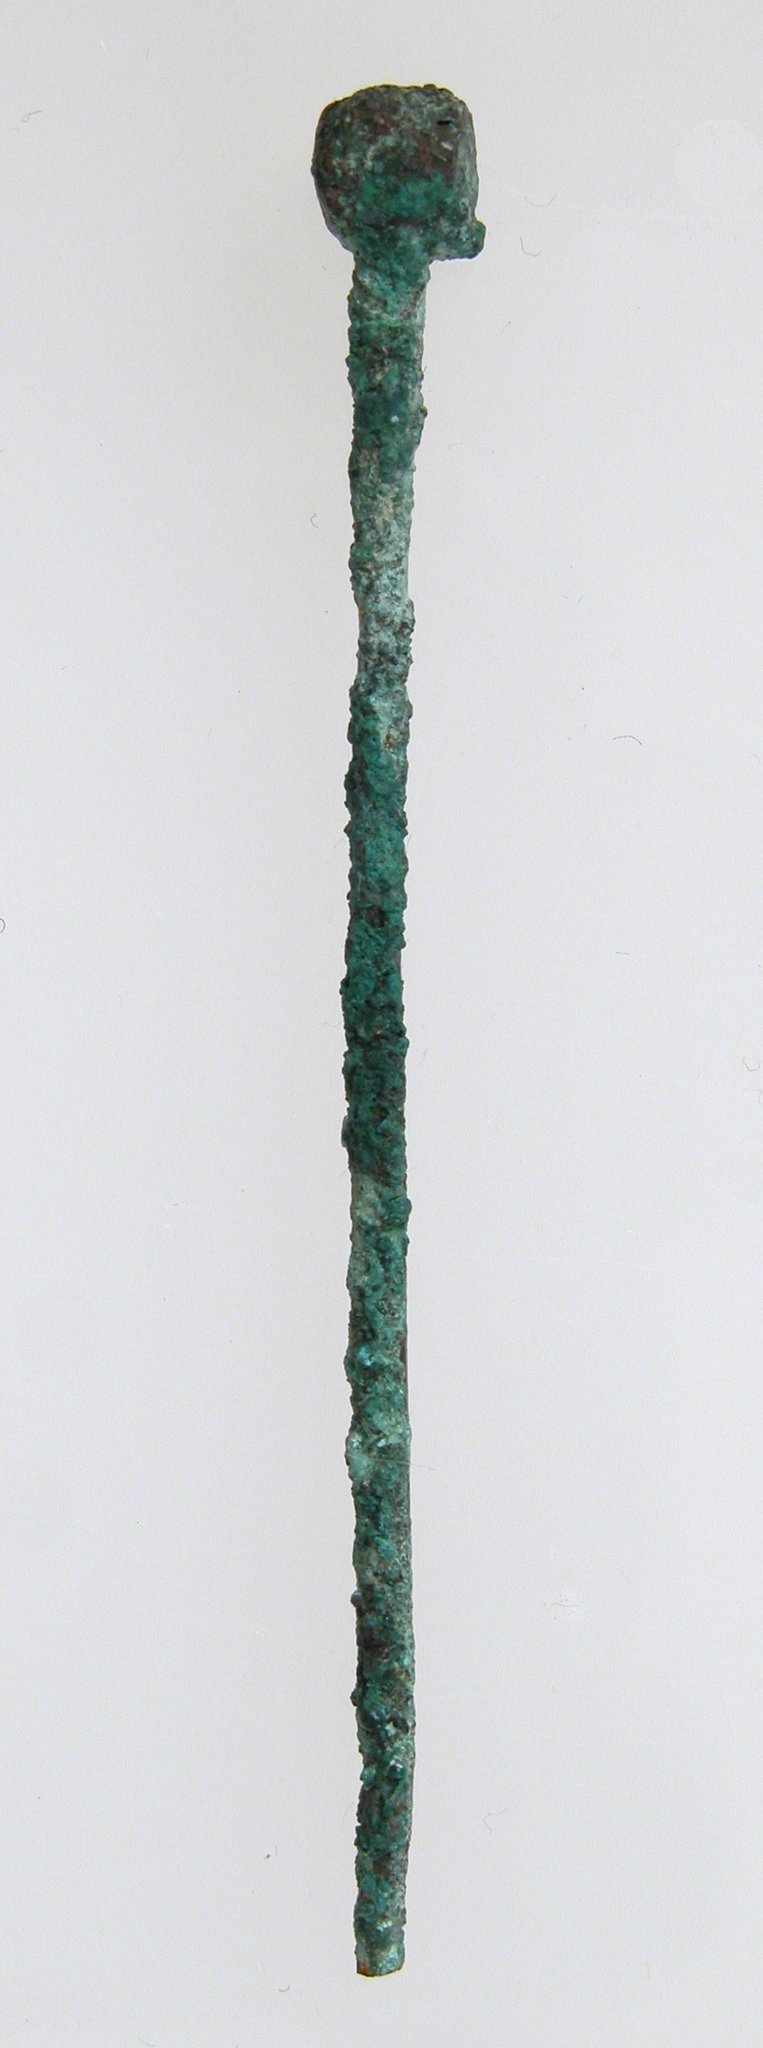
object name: hairpin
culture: roman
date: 200-500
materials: copper alloy